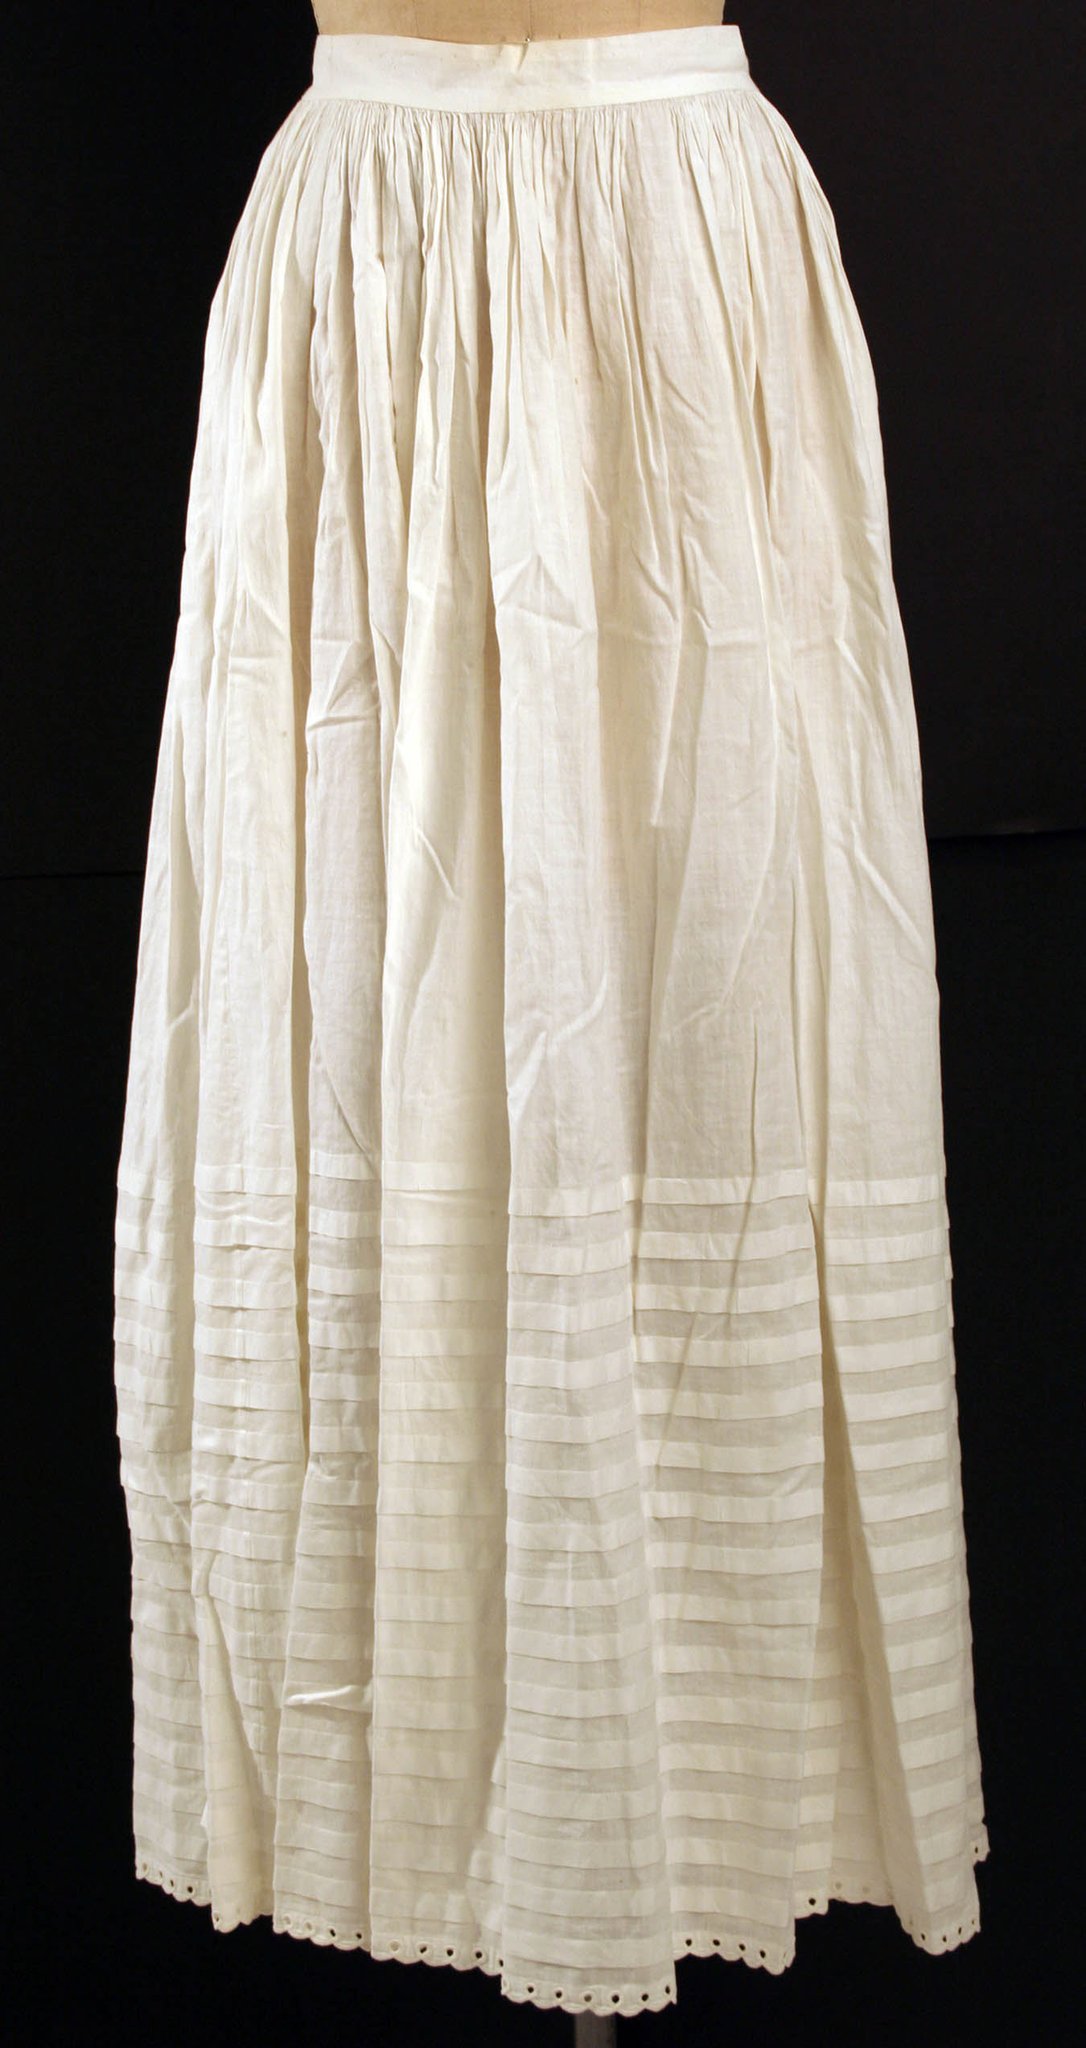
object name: underskirt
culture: american or european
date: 1850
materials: cotton